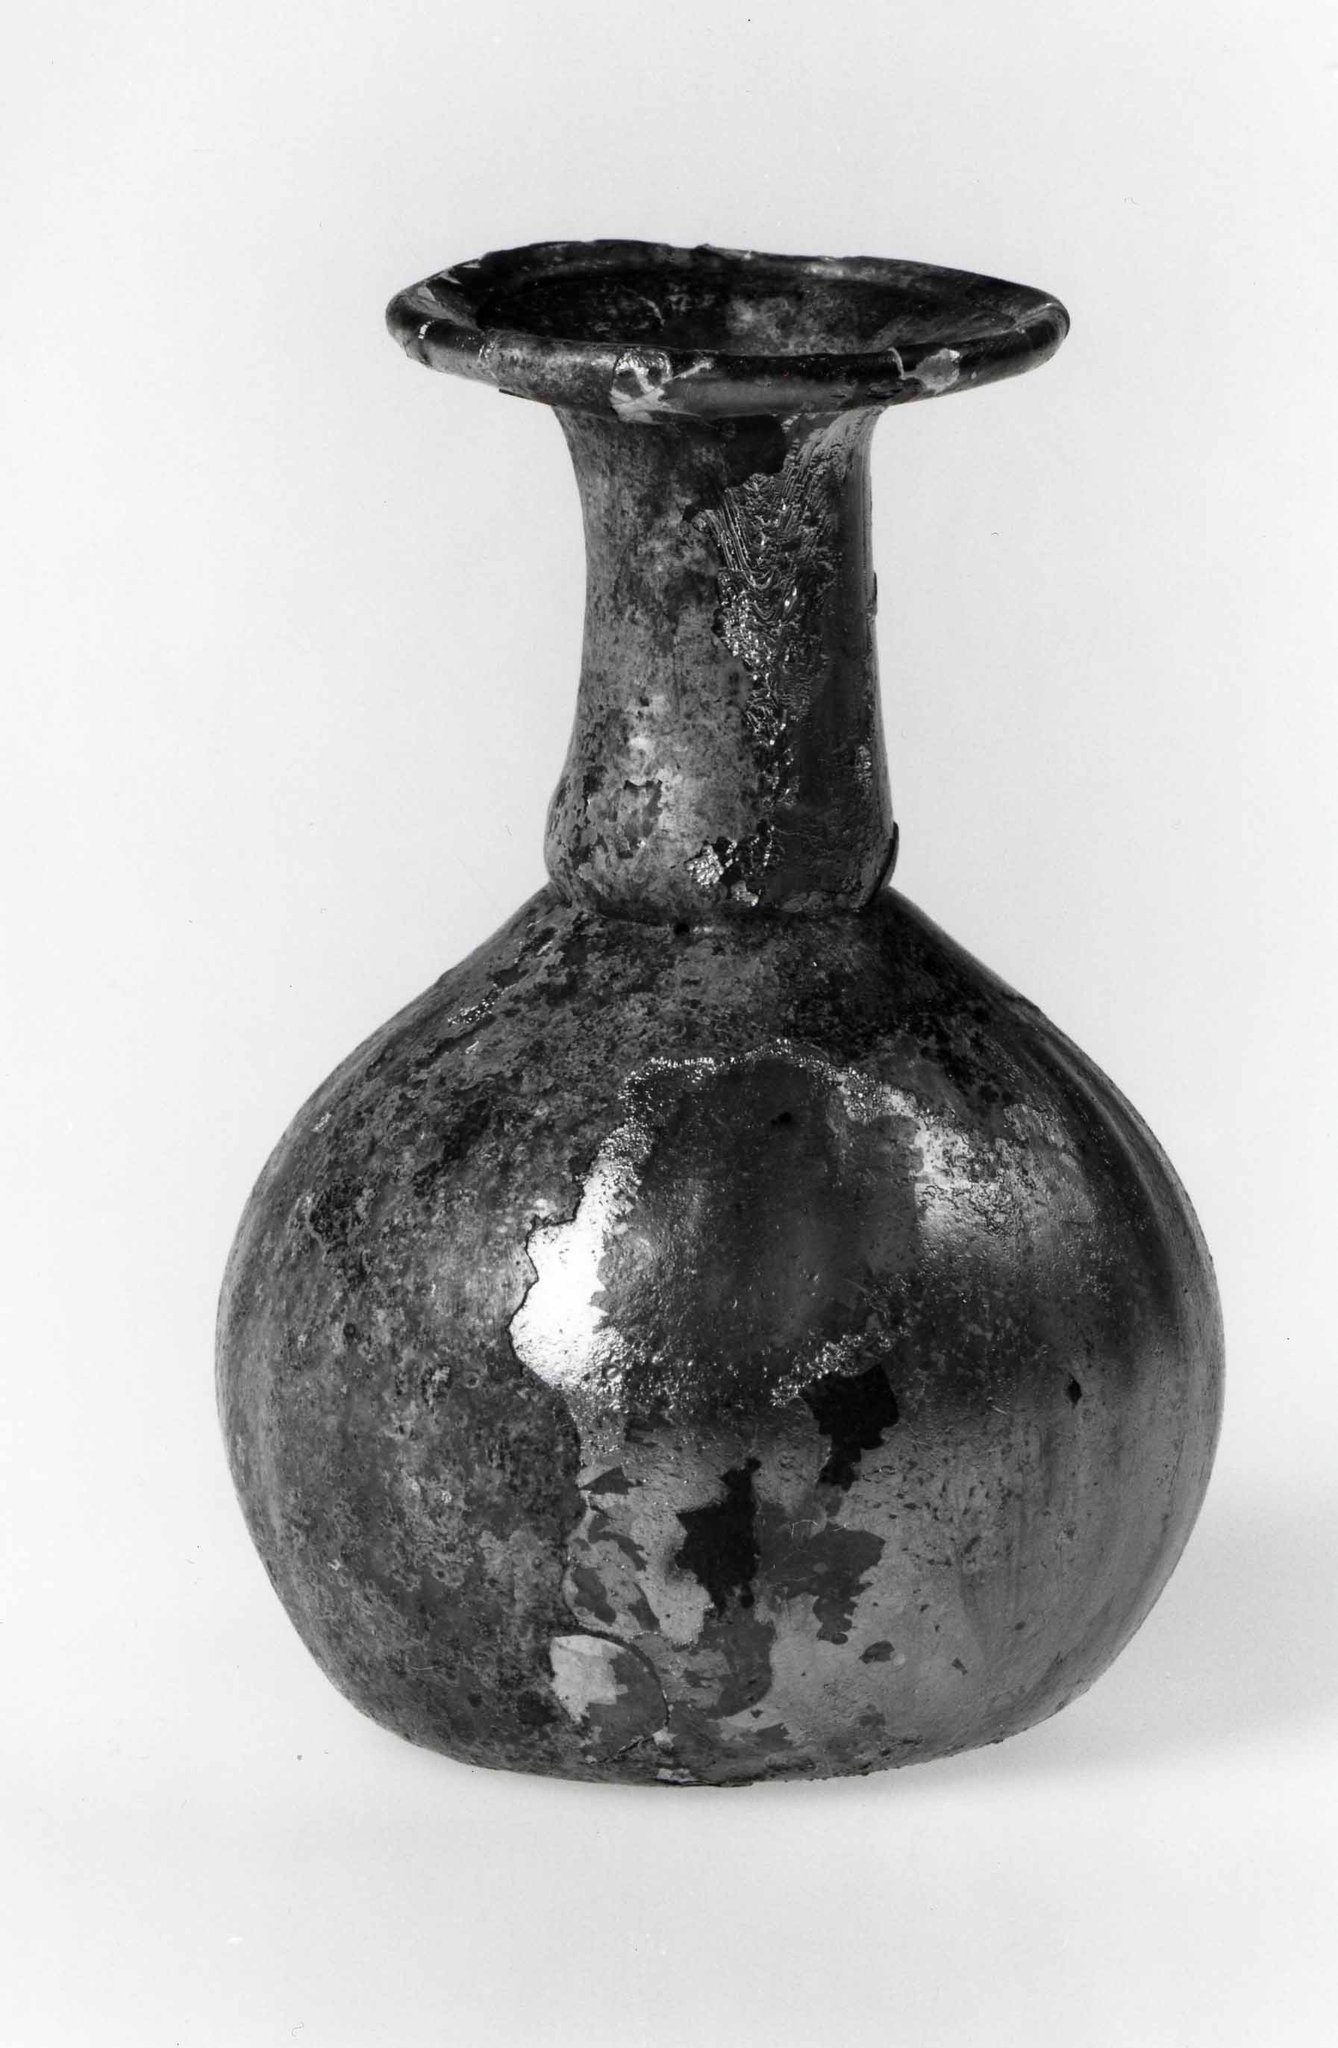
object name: dropper flask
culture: roman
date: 201-400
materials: glass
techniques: glassblowing, tooling